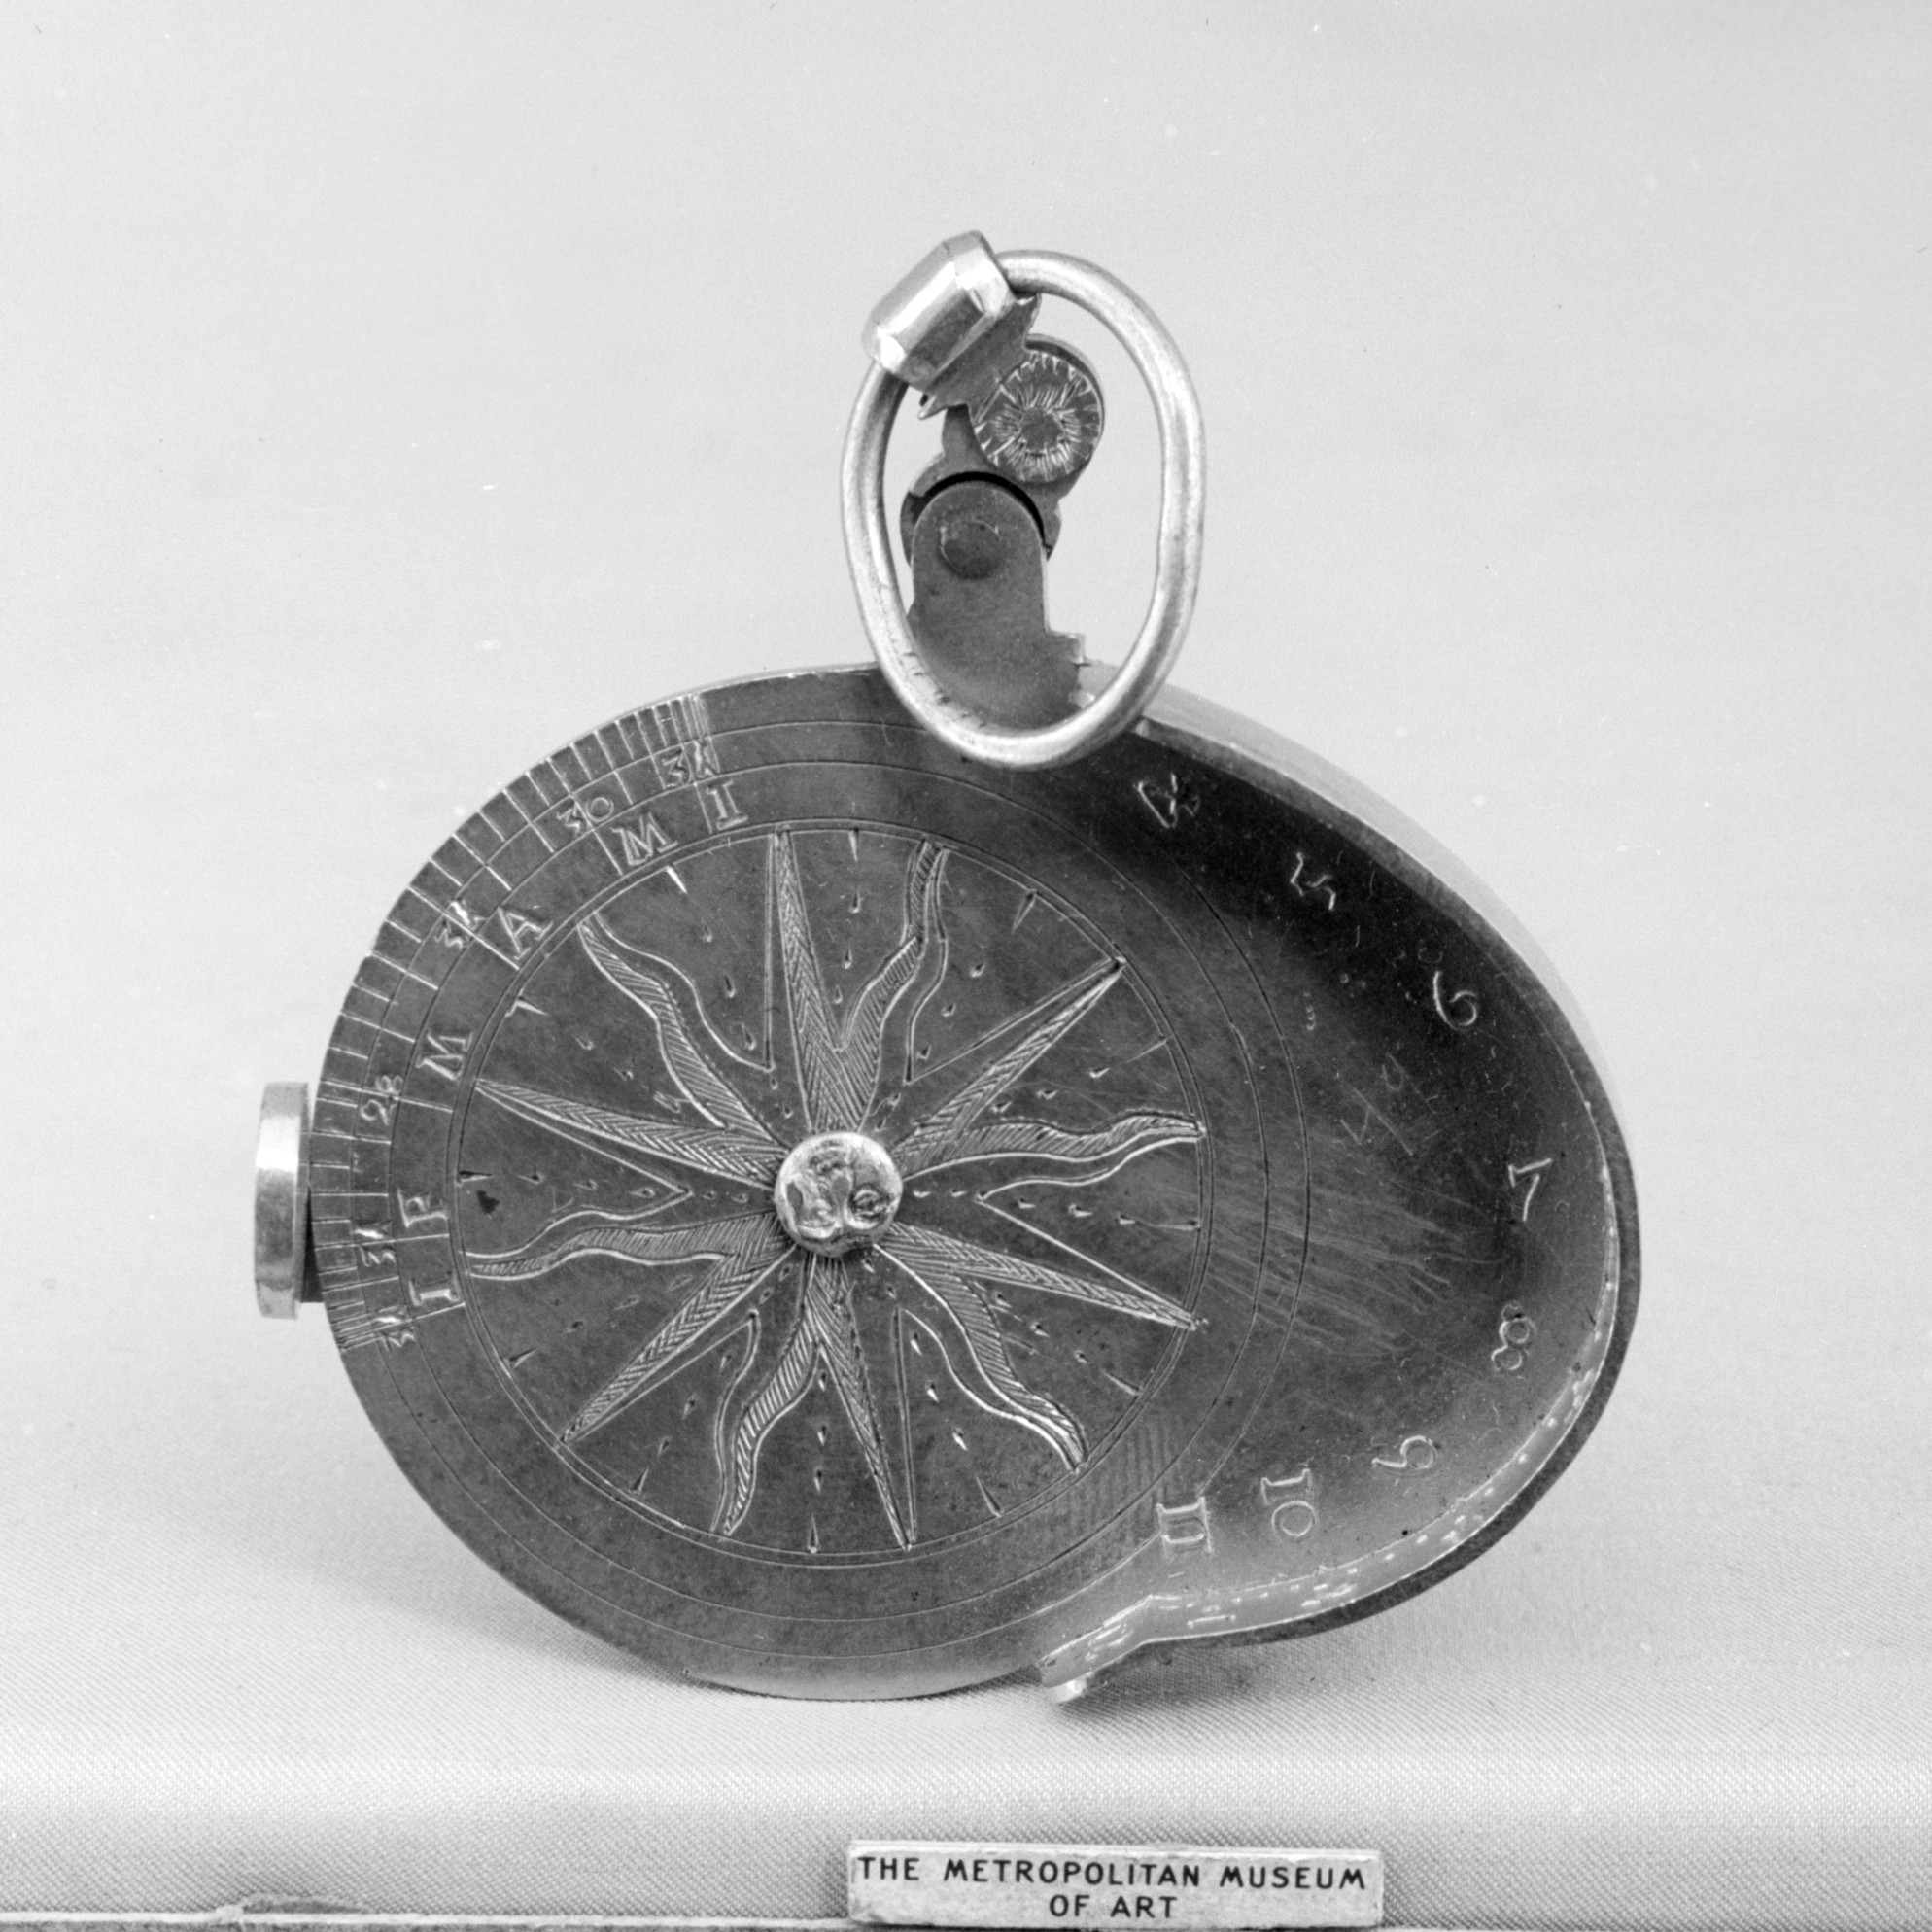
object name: vertical sundial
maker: h.w. w.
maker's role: maker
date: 1801-1900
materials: gilt brass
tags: sundials